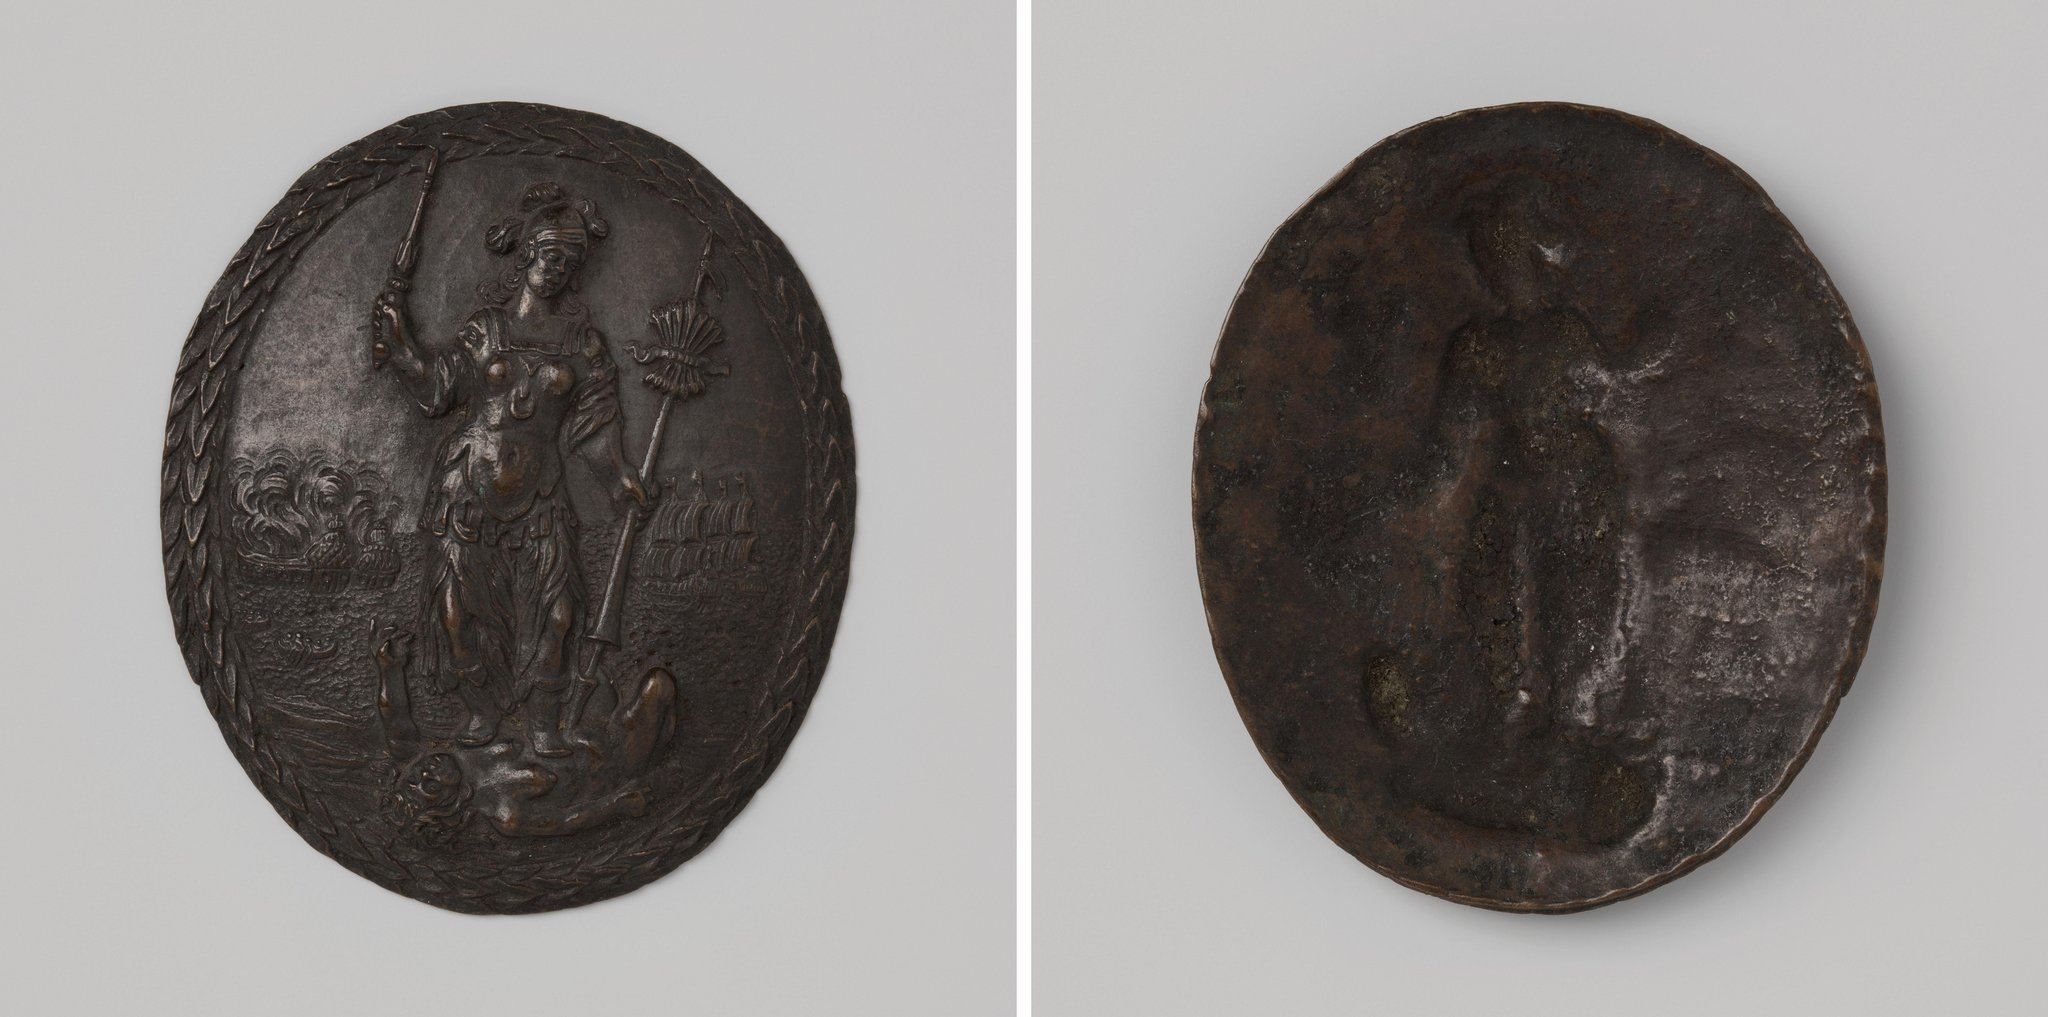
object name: plaque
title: Vrede van Breda en vernietiging van de Engelse vloot bij Chatham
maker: Anonymous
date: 1667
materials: bronze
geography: netherlands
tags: england, raid on the medway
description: ovale bronzen penning. Voorzijde: Nederlandse maagd met scepter en speer met pijlenbundel vertrapt Nijd die op grond ligt, op achtergrond het verbranden van de Engelse vloot bij Chatham binnen lauwerkrans. Keerzijde: blanco.